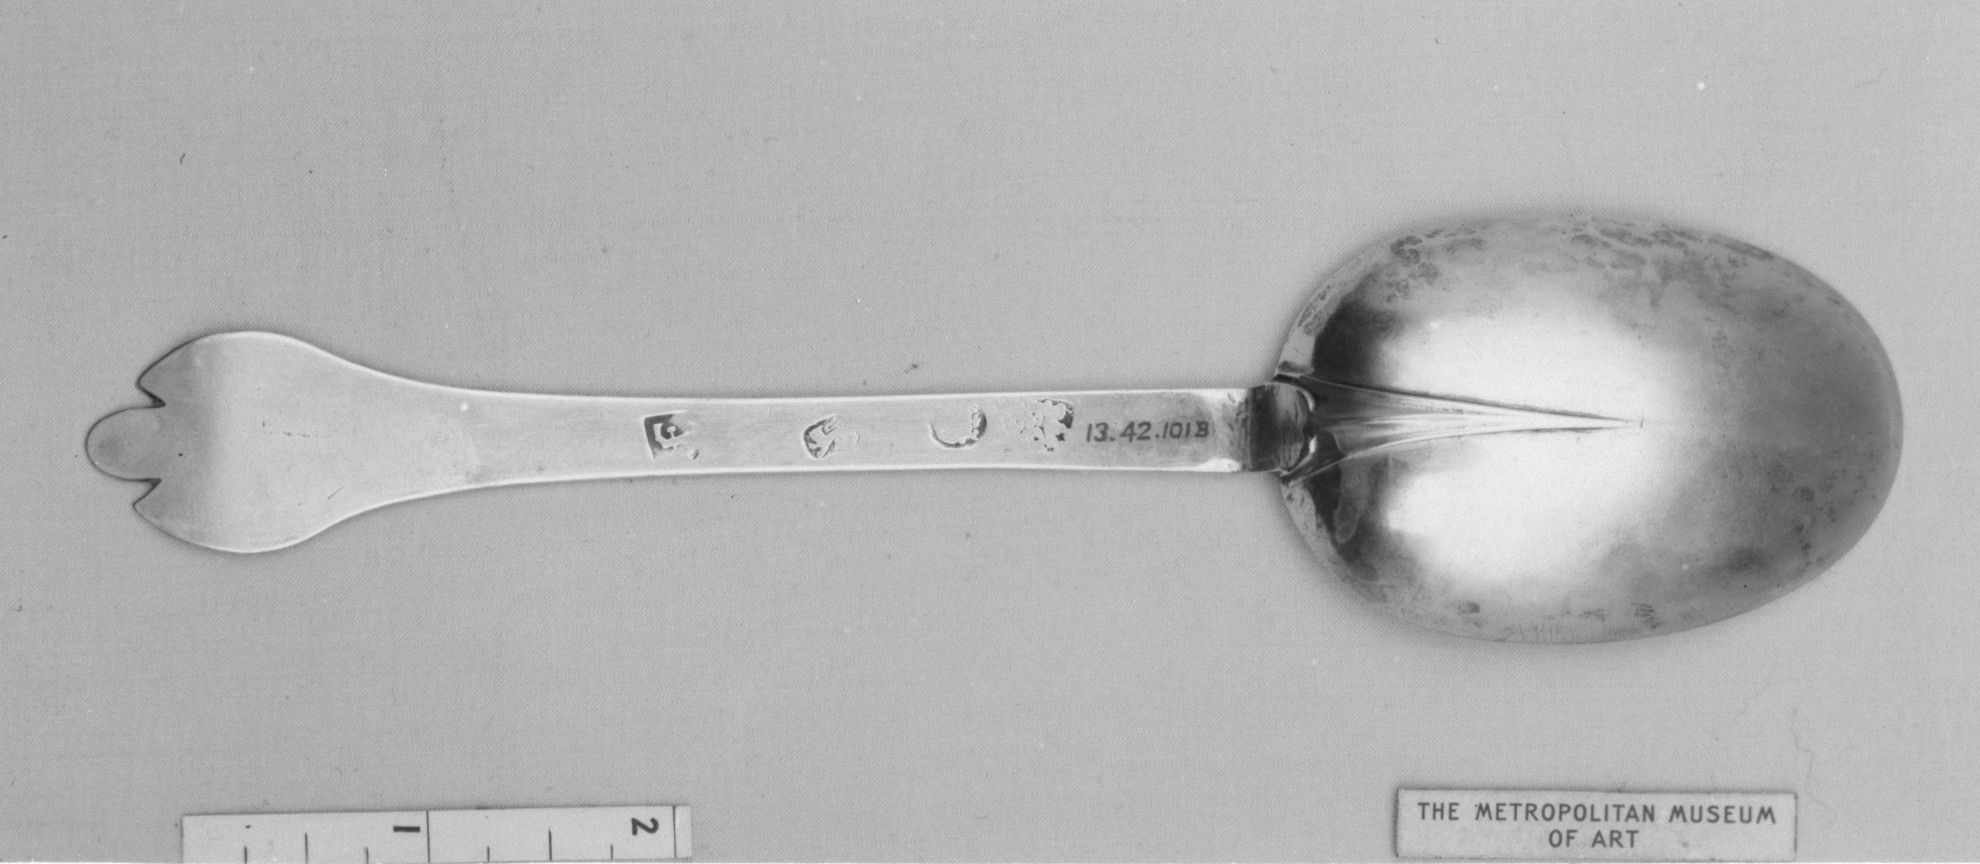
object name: spoon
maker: lawrence coles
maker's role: maker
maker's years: 1669-1714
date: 1683-1684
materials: silver